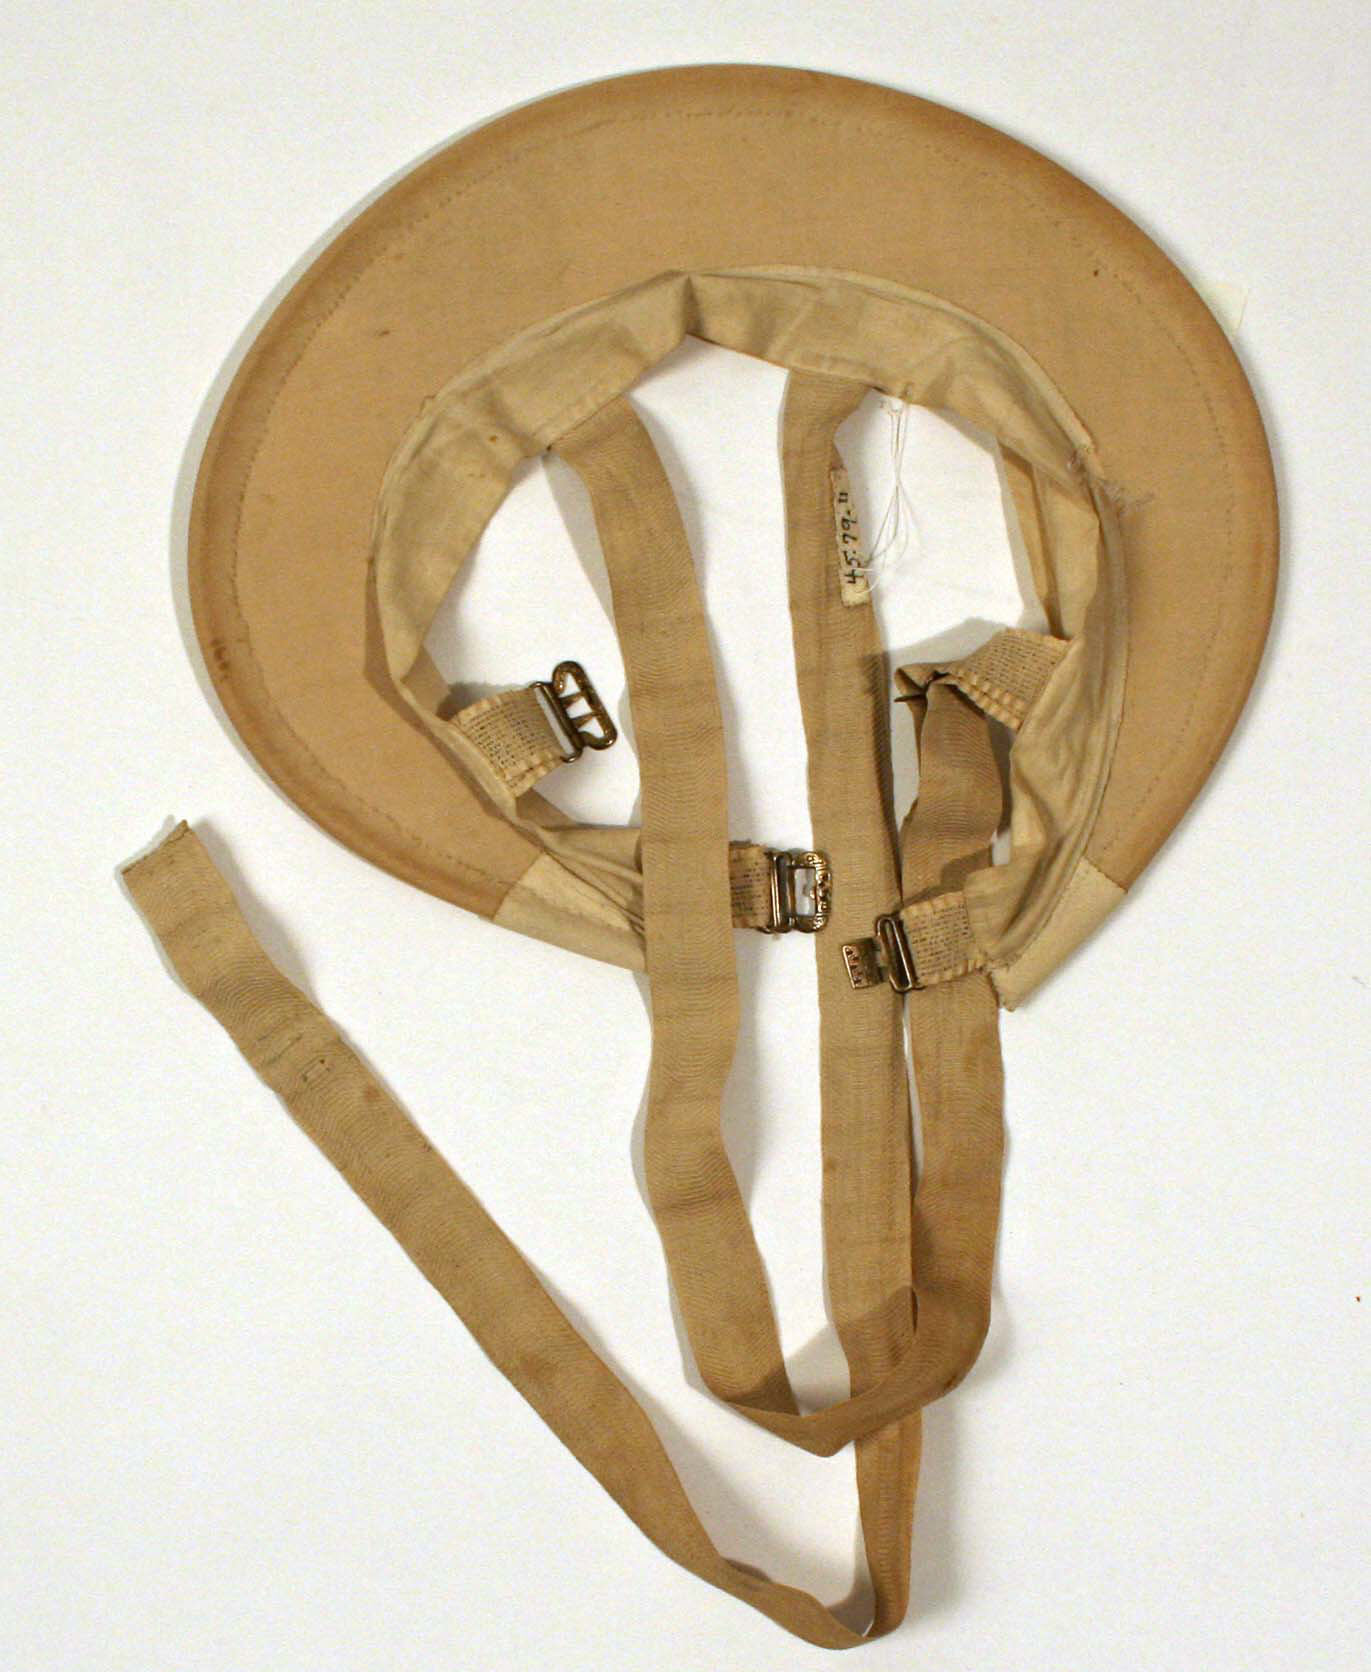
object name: bustle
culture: american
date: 1850-1875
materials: cotton